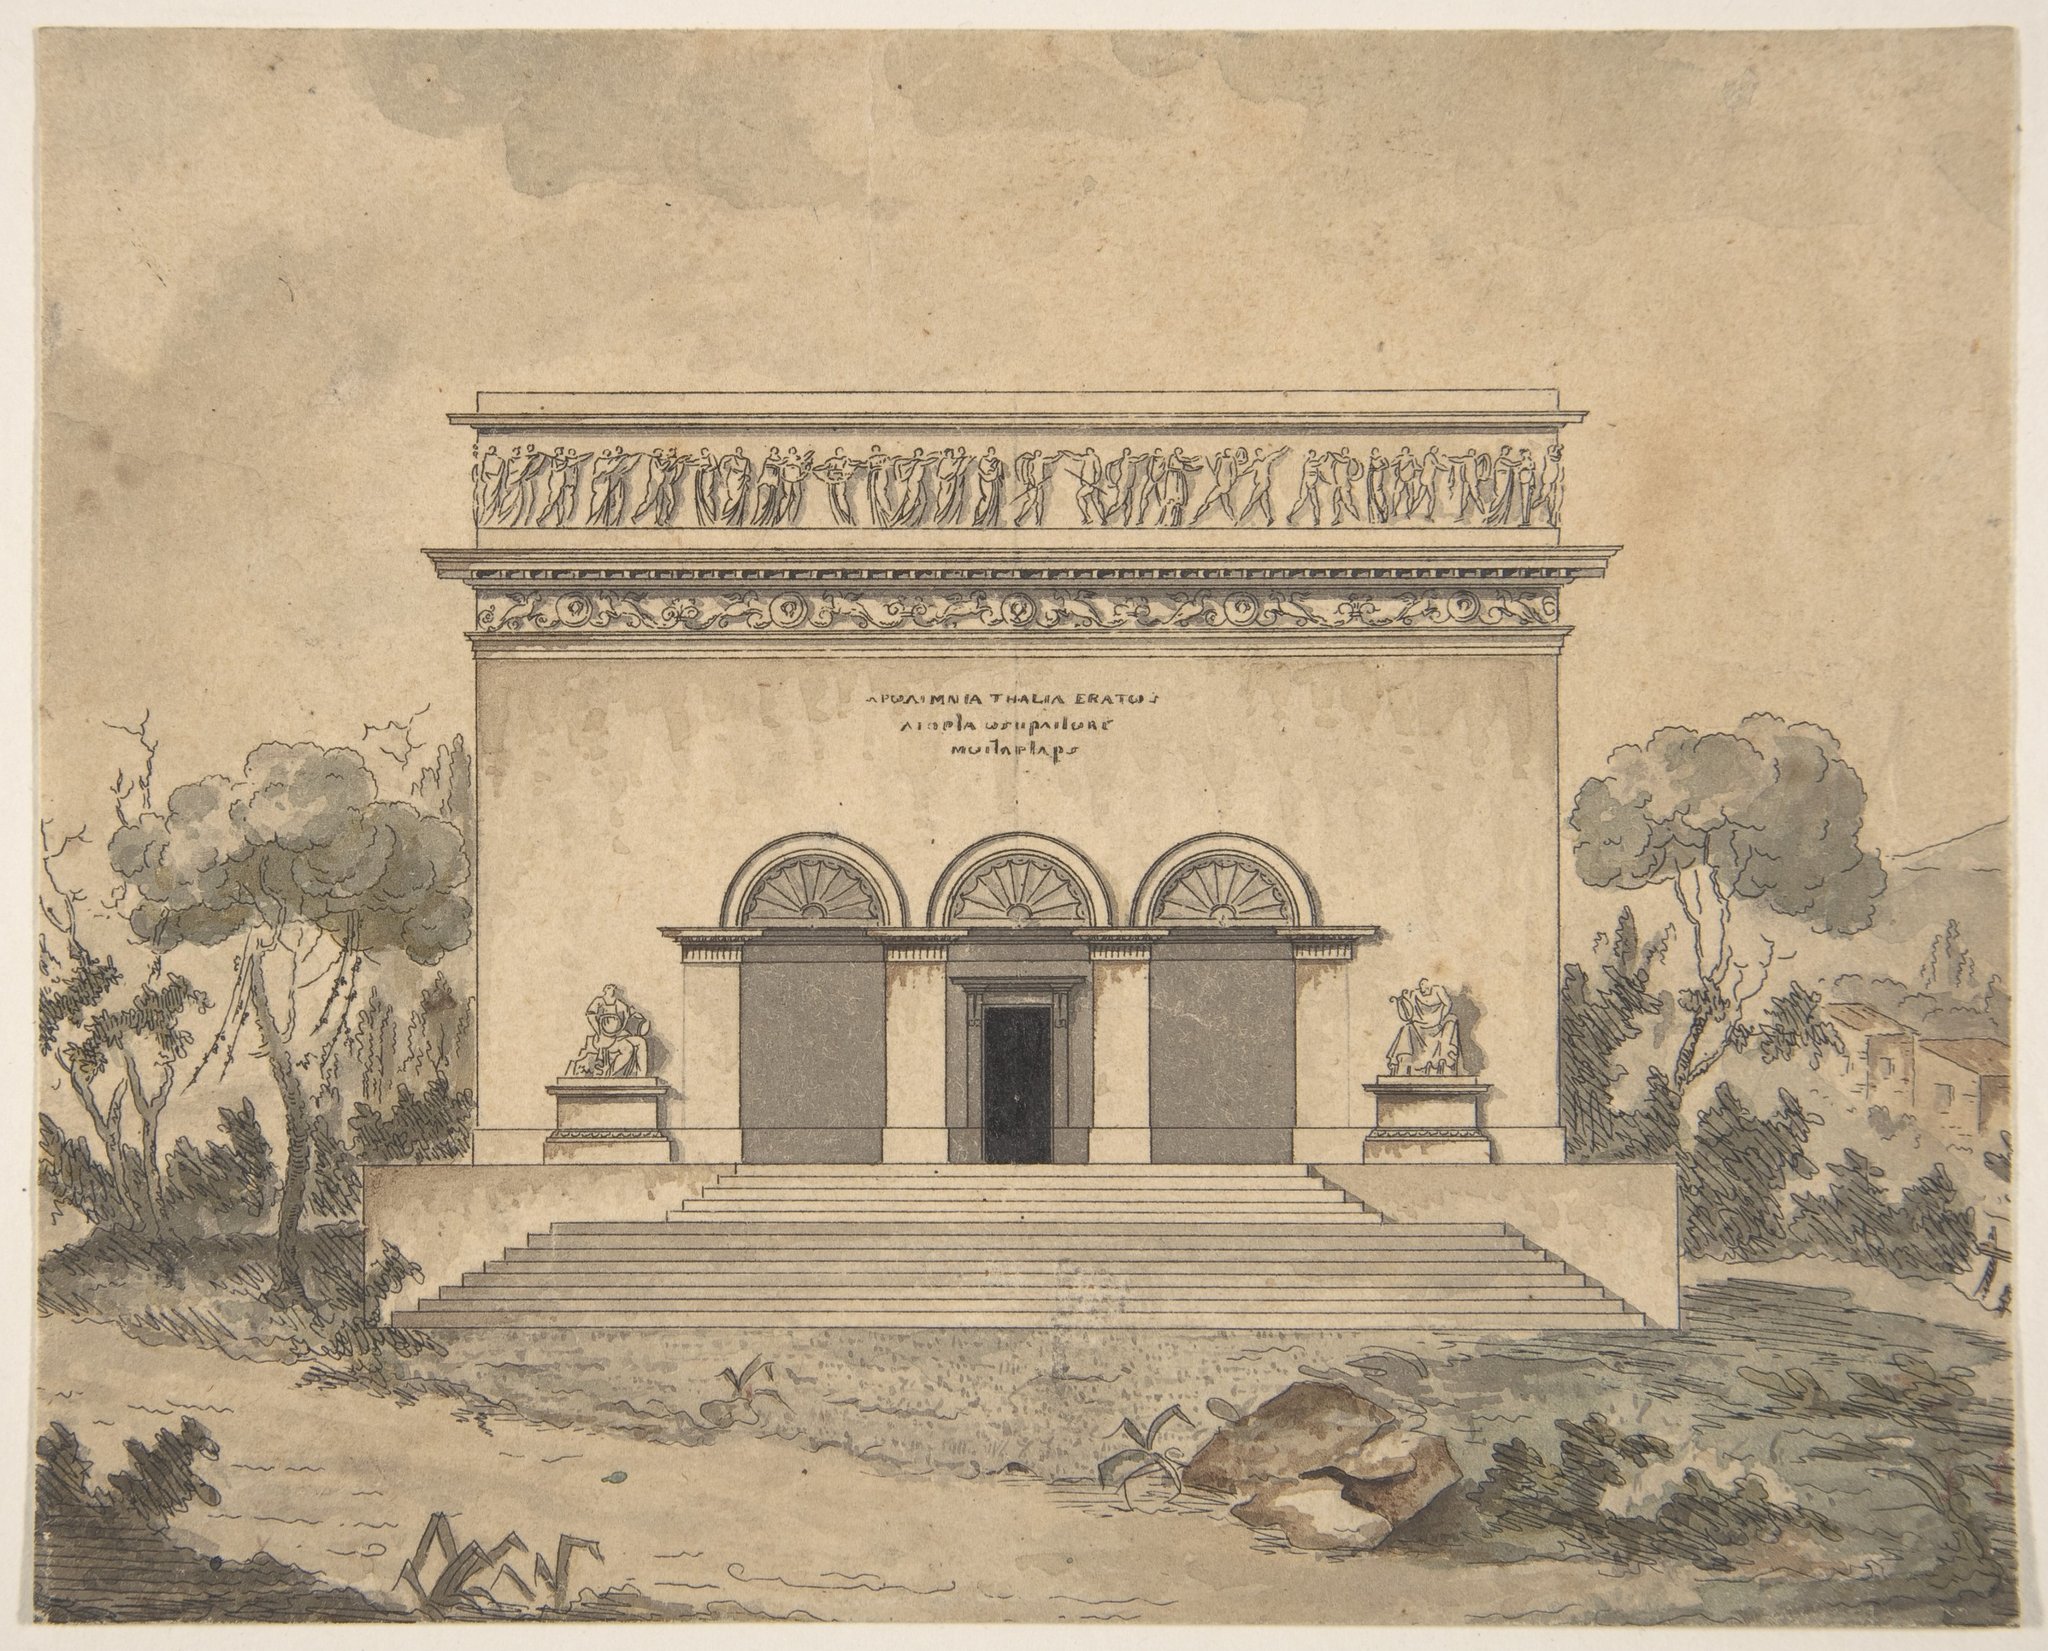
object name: drawing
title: Design for the Exterior of a Theater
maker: anonymous, french, 19th century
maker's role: artist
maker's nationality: french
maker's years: 1800-1900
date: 1800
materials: ink, watercolor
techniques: pen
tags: theatre,architecture